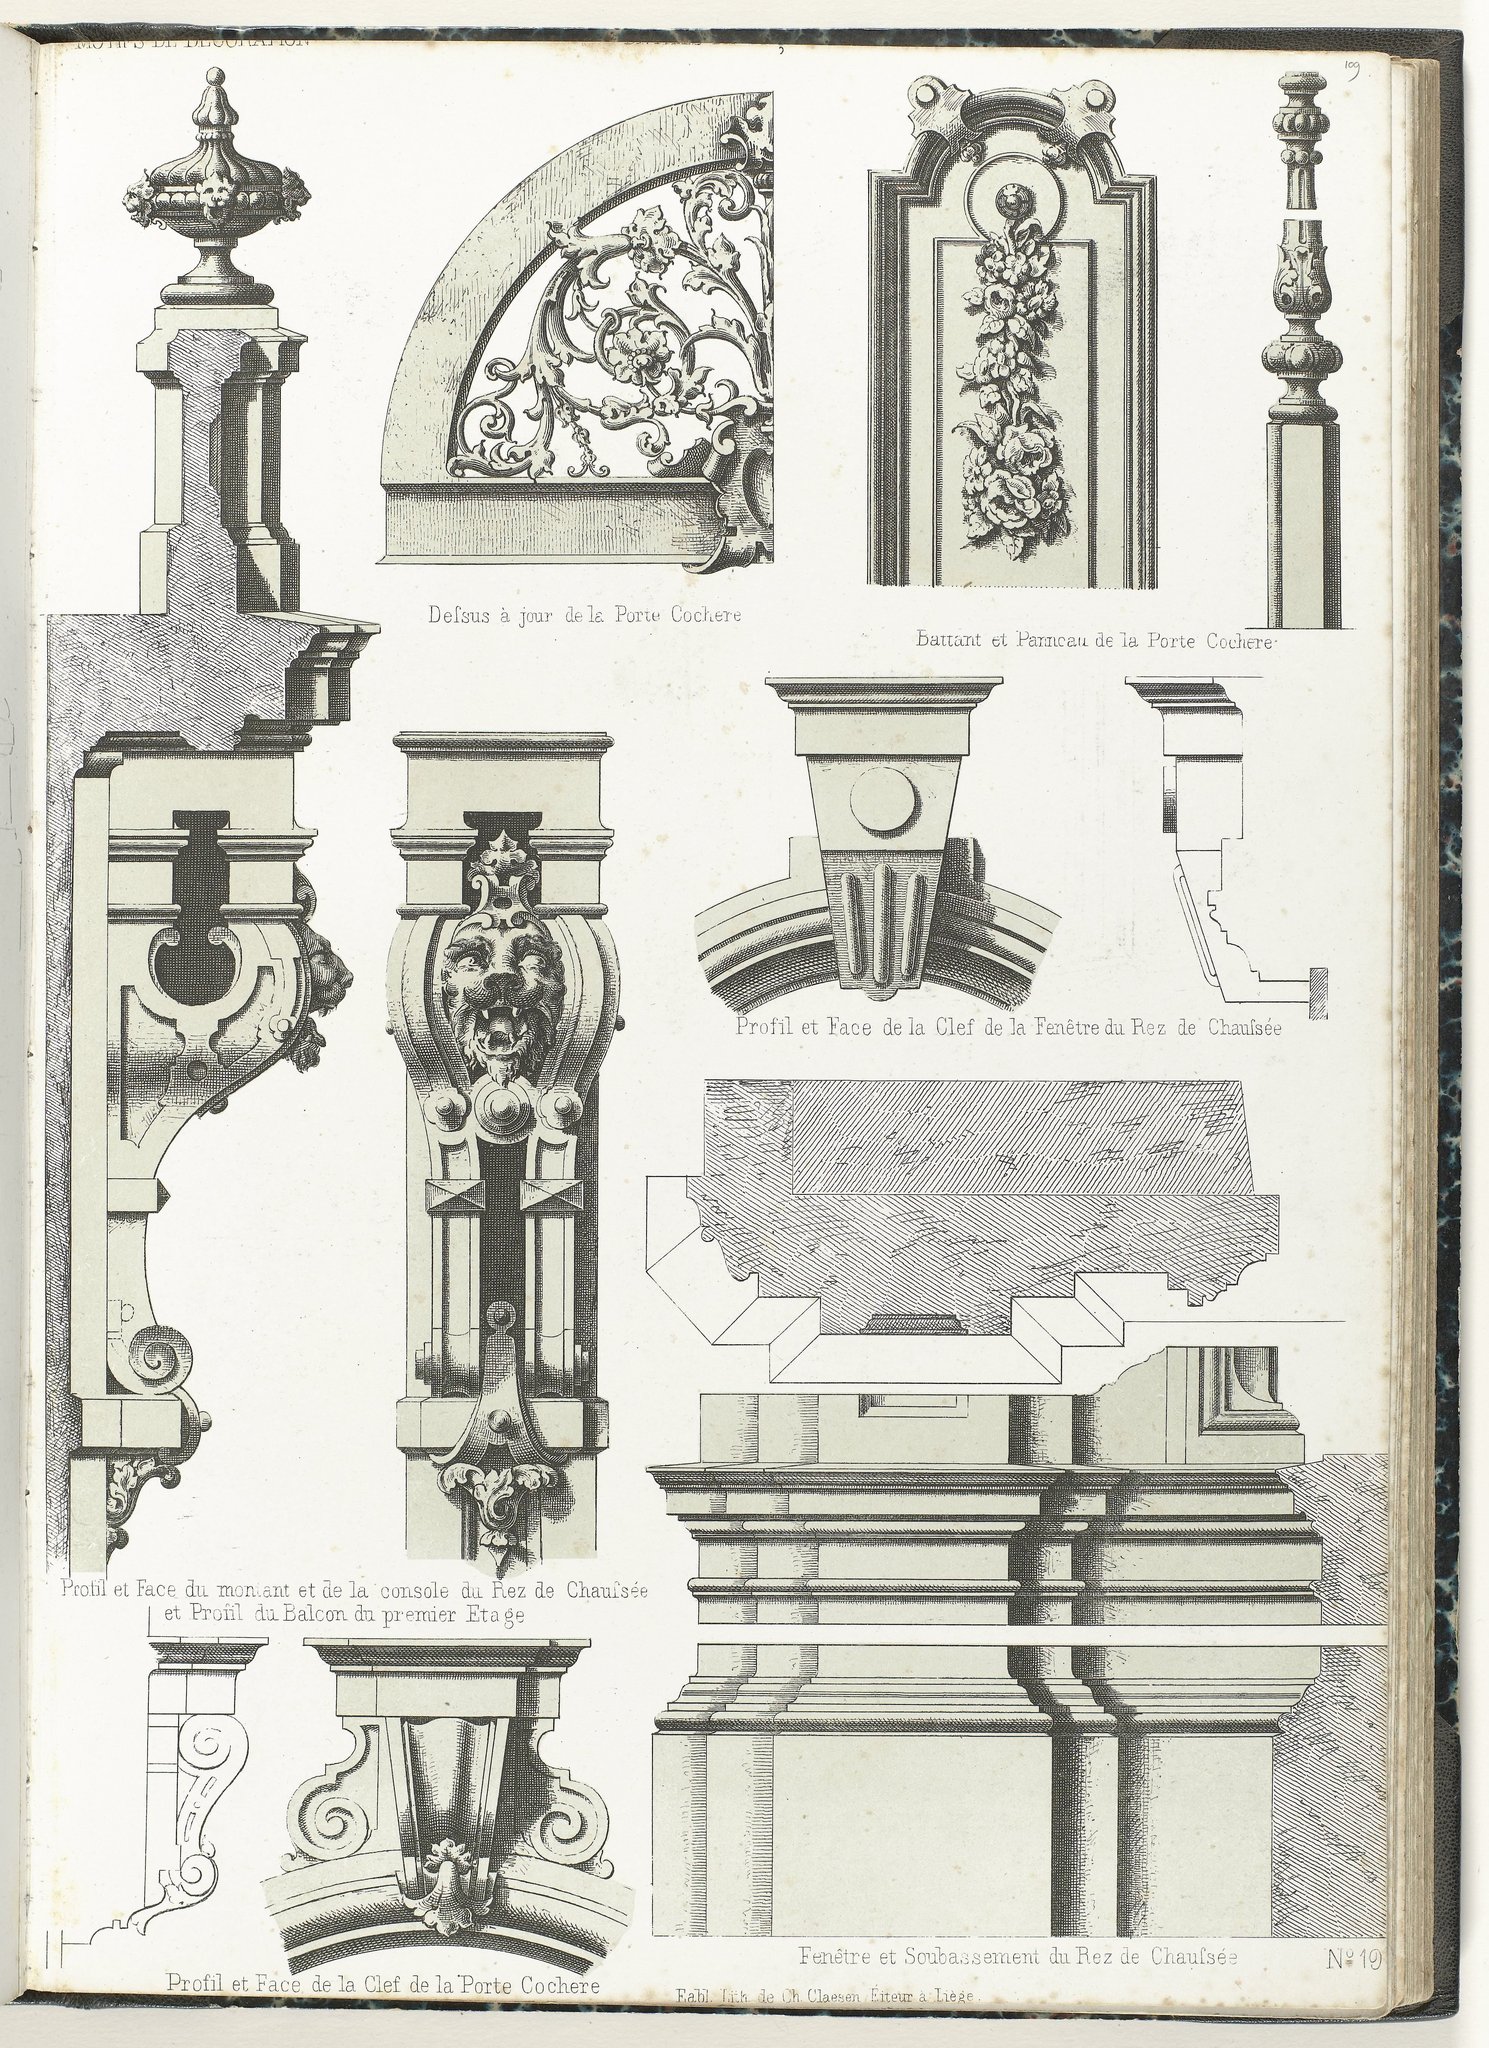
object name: print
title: Architecturale elementen van porte-cochère, begane grond en eerste etage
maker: Anonymous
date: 1866-1900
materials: paper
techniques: tone lithography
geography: liège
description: Bovenaan staan onderdelen van een porte-cochère afgebeeld, het paneel in het midden is gedecoreerd met een guirlande van bloemen en bladeren. Onder de elementen staat in het Frans vermeld wat het is. Rechtsonder: N° 19.